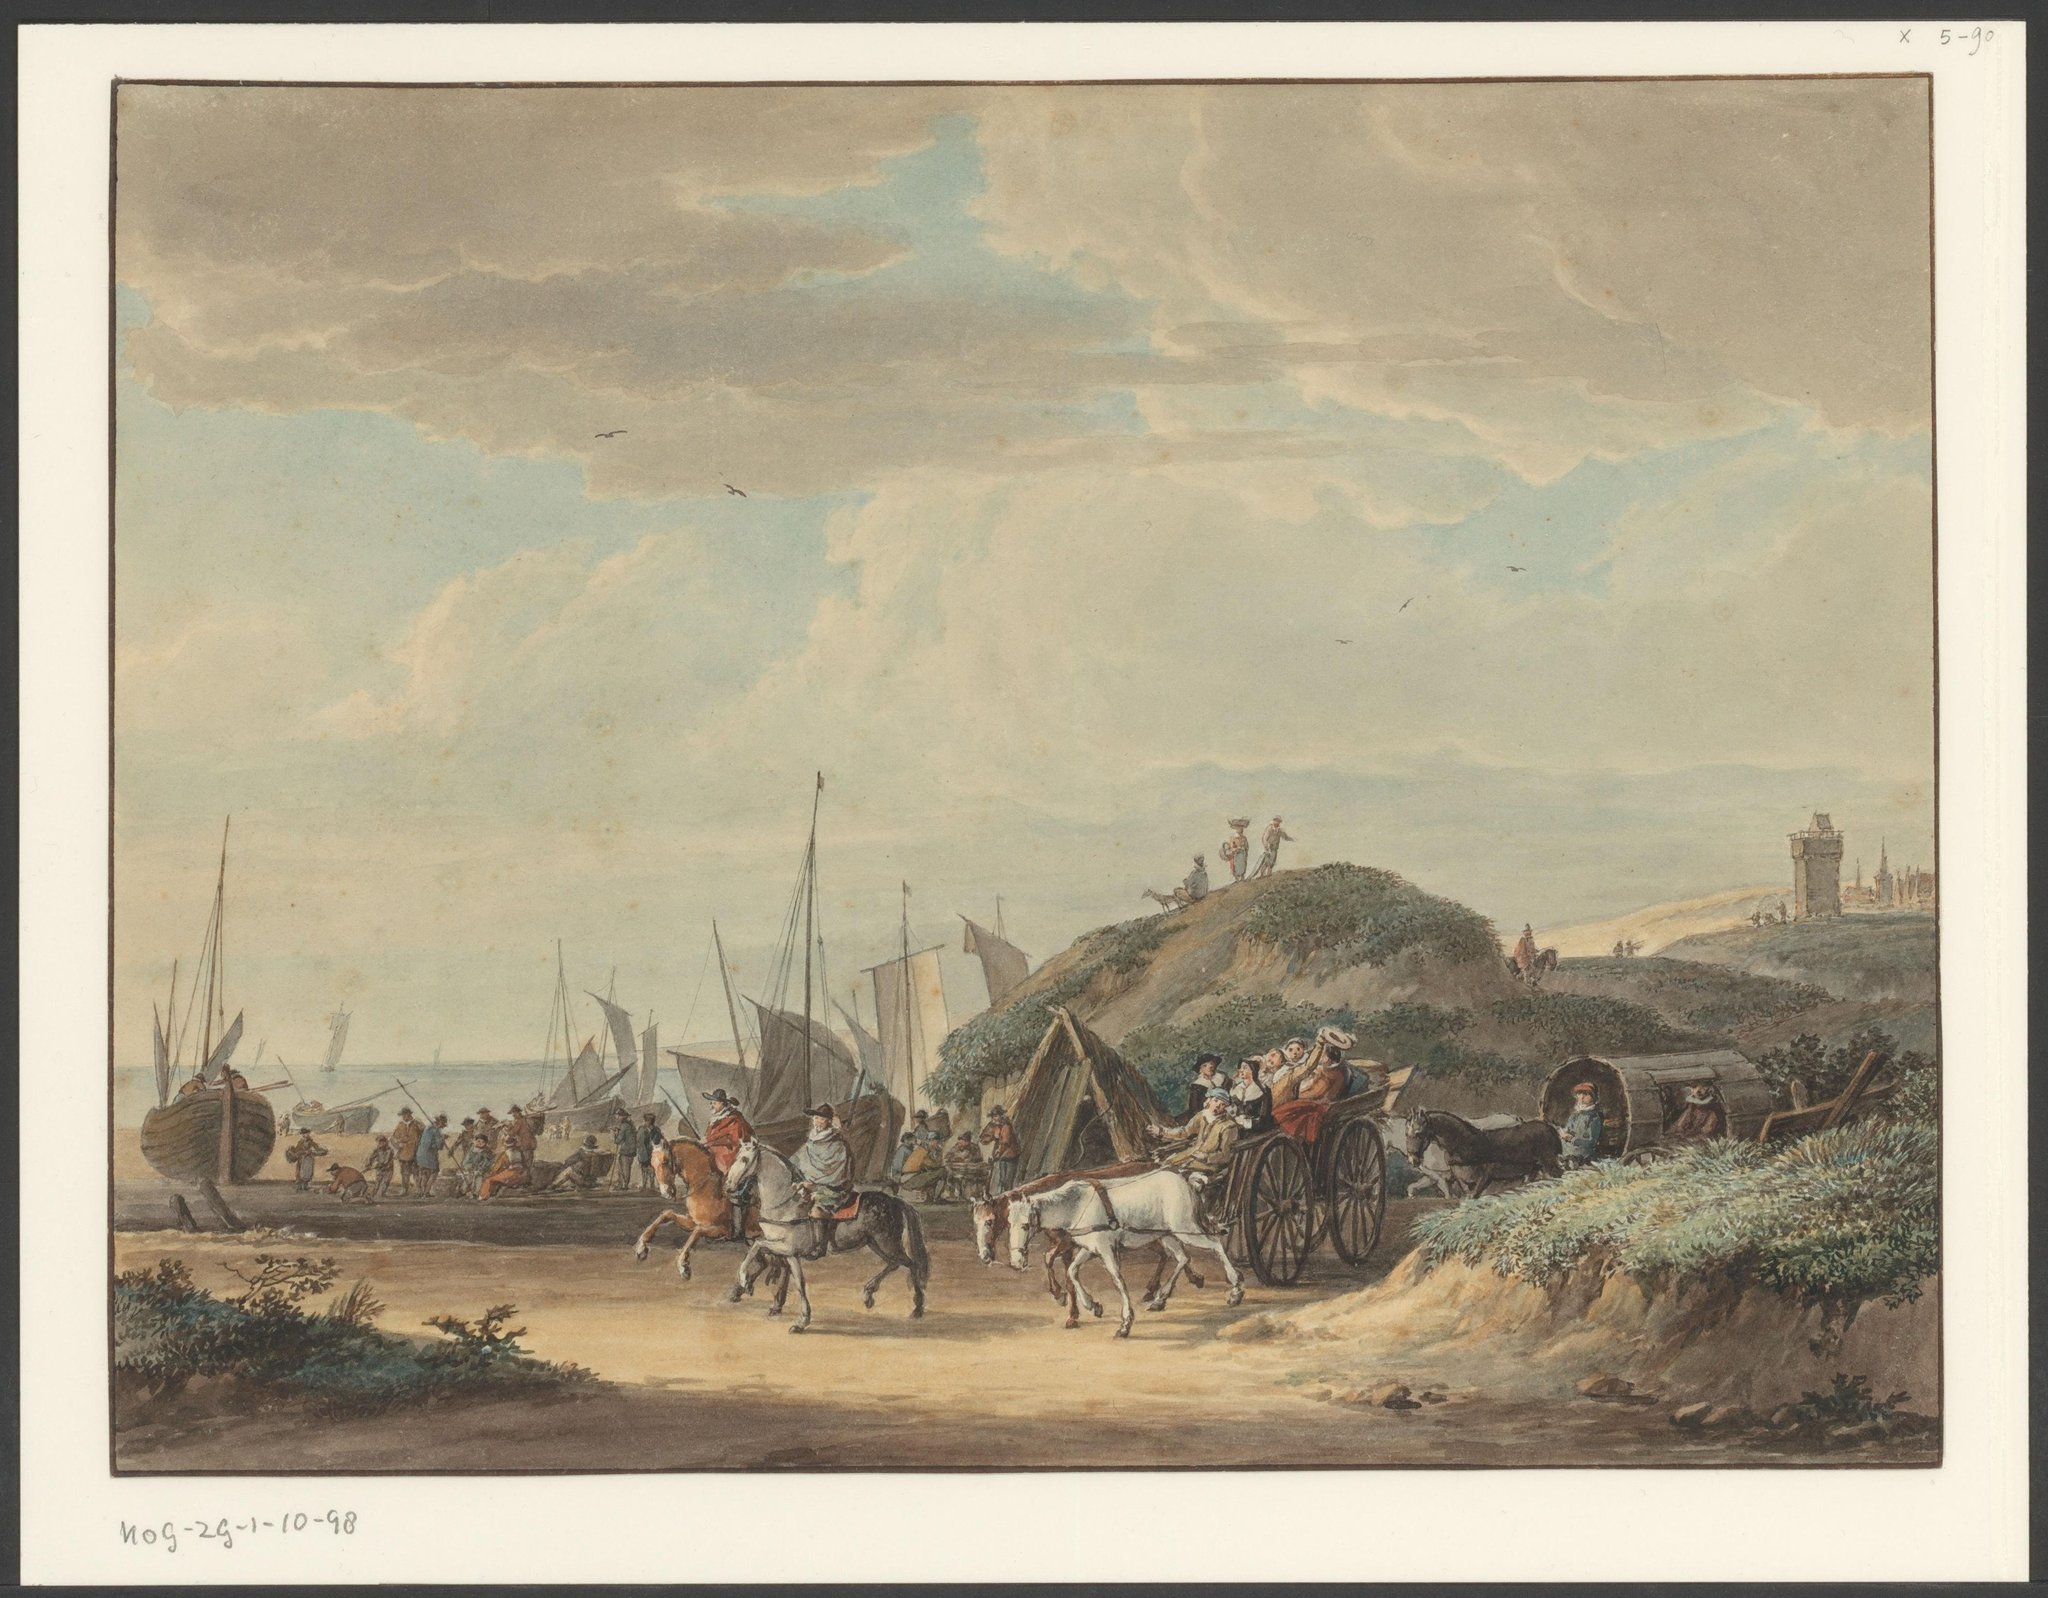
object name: drawing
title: Boerenwagen in de duinen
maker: Anonymous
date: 1700-1799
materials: ink, paper, watercolor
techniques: brush, pen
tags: dune coast, sailing-ship, sailing-boat, four-wheeled vehicle drawn by more than three animals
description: Onderwerpsrubrieken binnen de Atlas Zeden en Gewoonten: Handel, nijverheid en verkeer, Vervoermiddelen te land en te water, vervoermiddelen te land, Sjeezen en Boerenwagens.